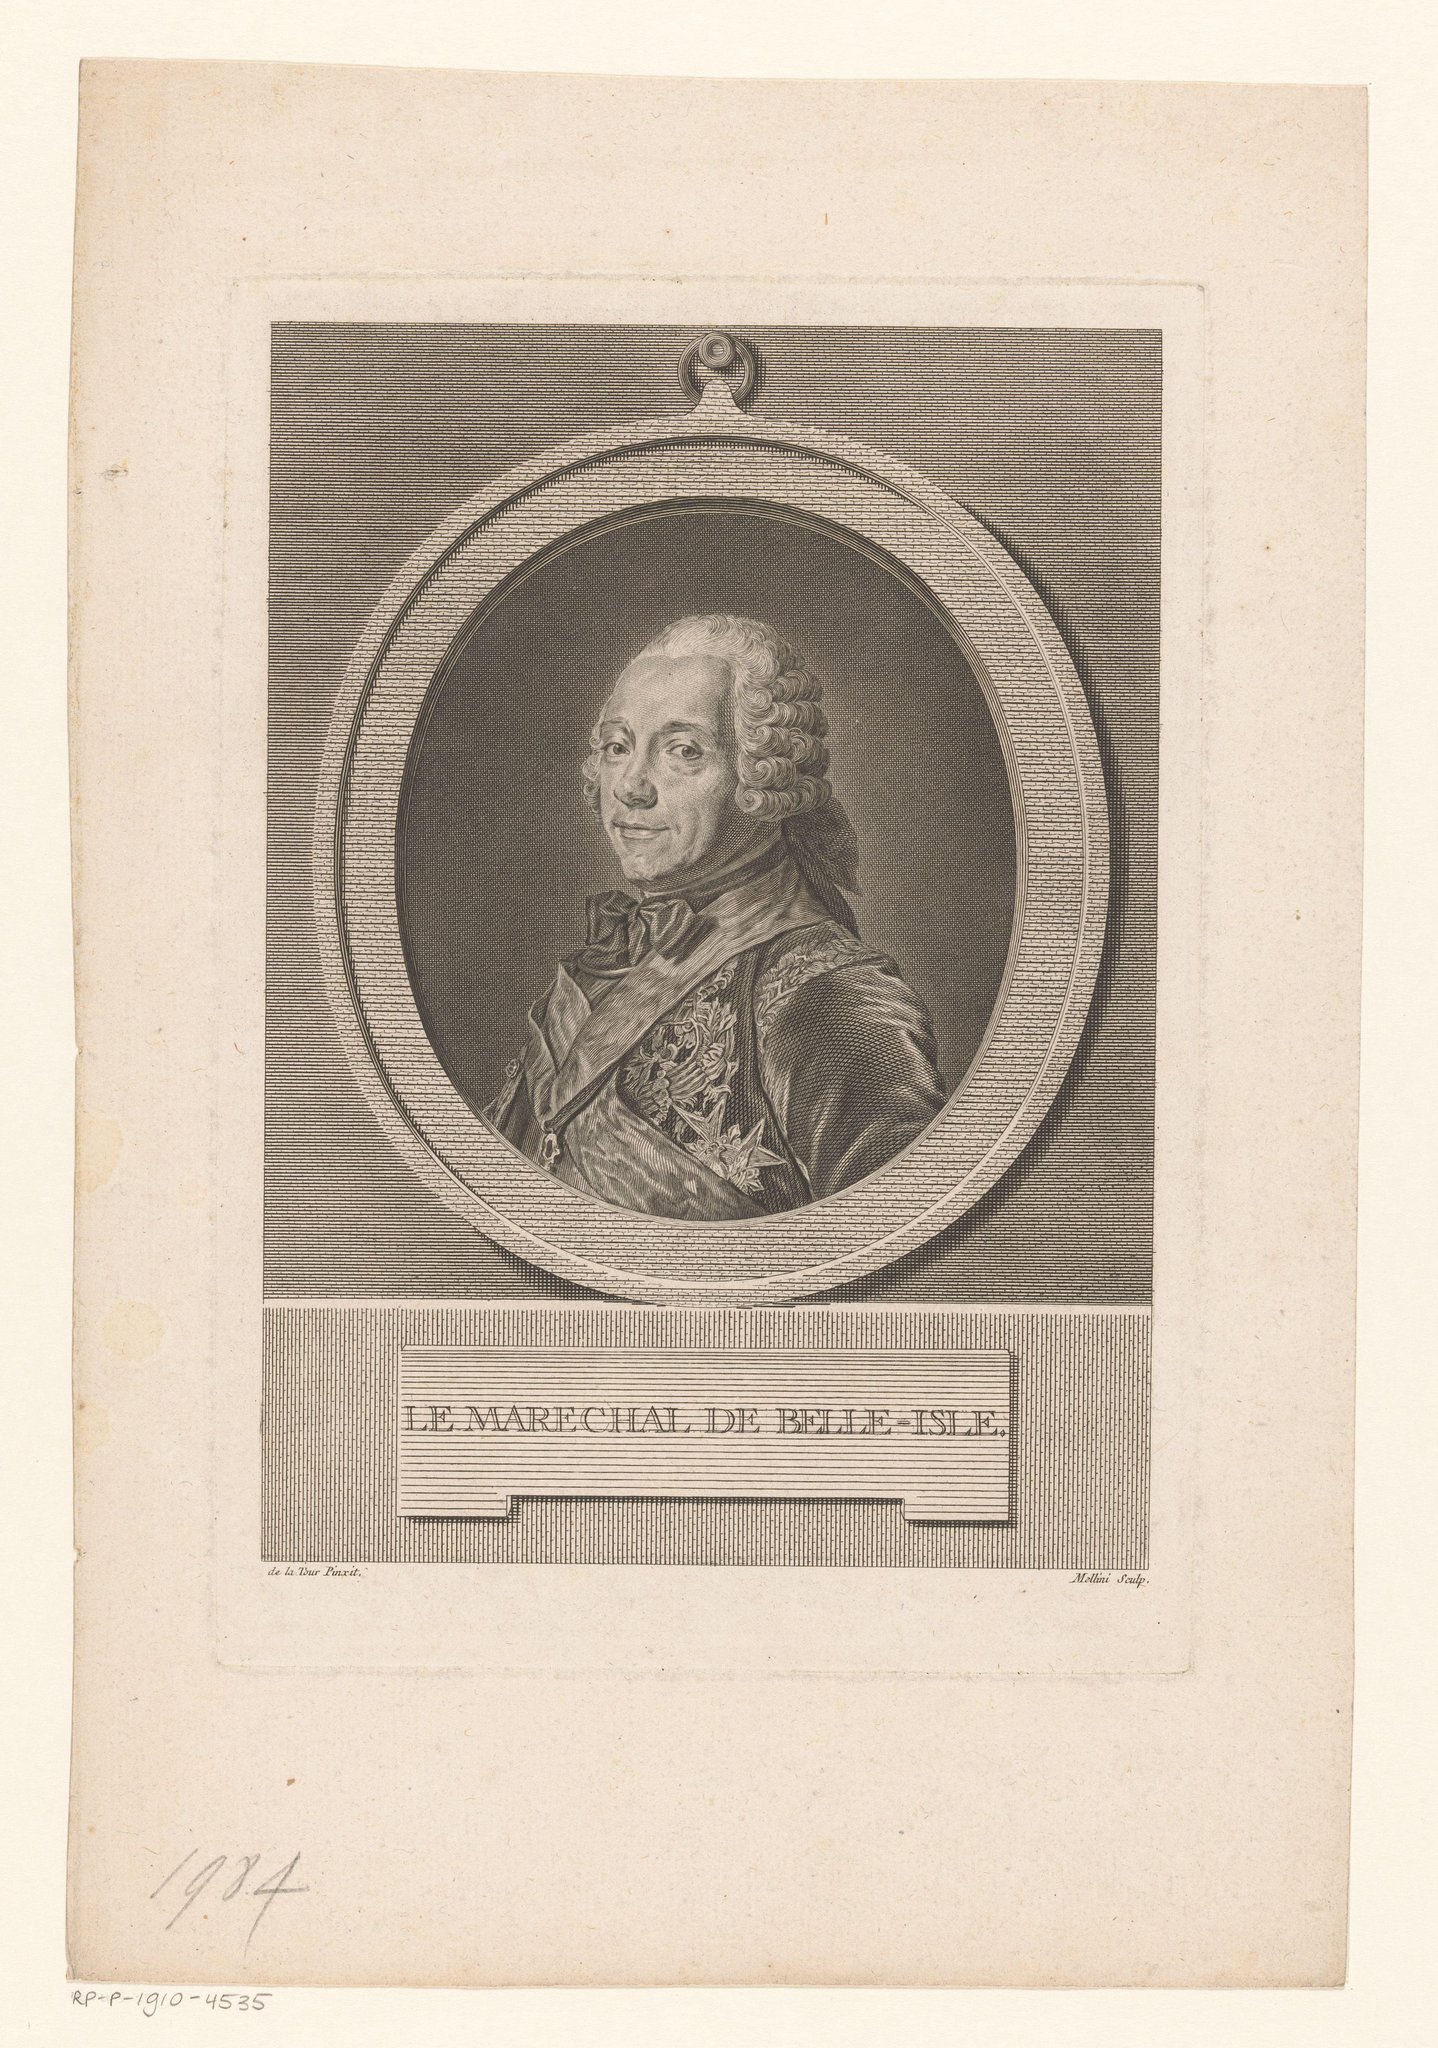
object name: print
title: Portret van Charles Louis Auguste Fouquet, duc de Belle-Isle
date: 1745-1795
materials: paper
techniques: engraving, etching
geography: france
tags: charles louis auguste fouquet (duc de belle-isle), historical persons, ruler, sovereign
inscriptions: collector's mark: Lugt 2228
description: Naar een pastel door Maurice Quentin de La Tour in een privé collectie.